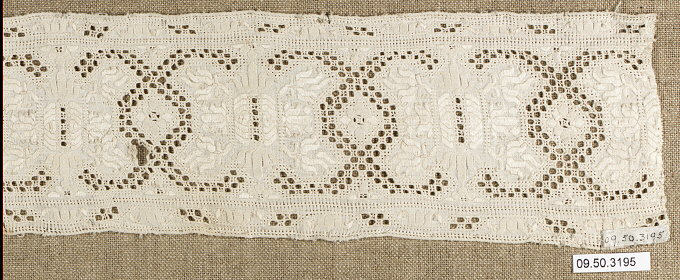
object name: band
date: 1601-1800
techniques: embroidery